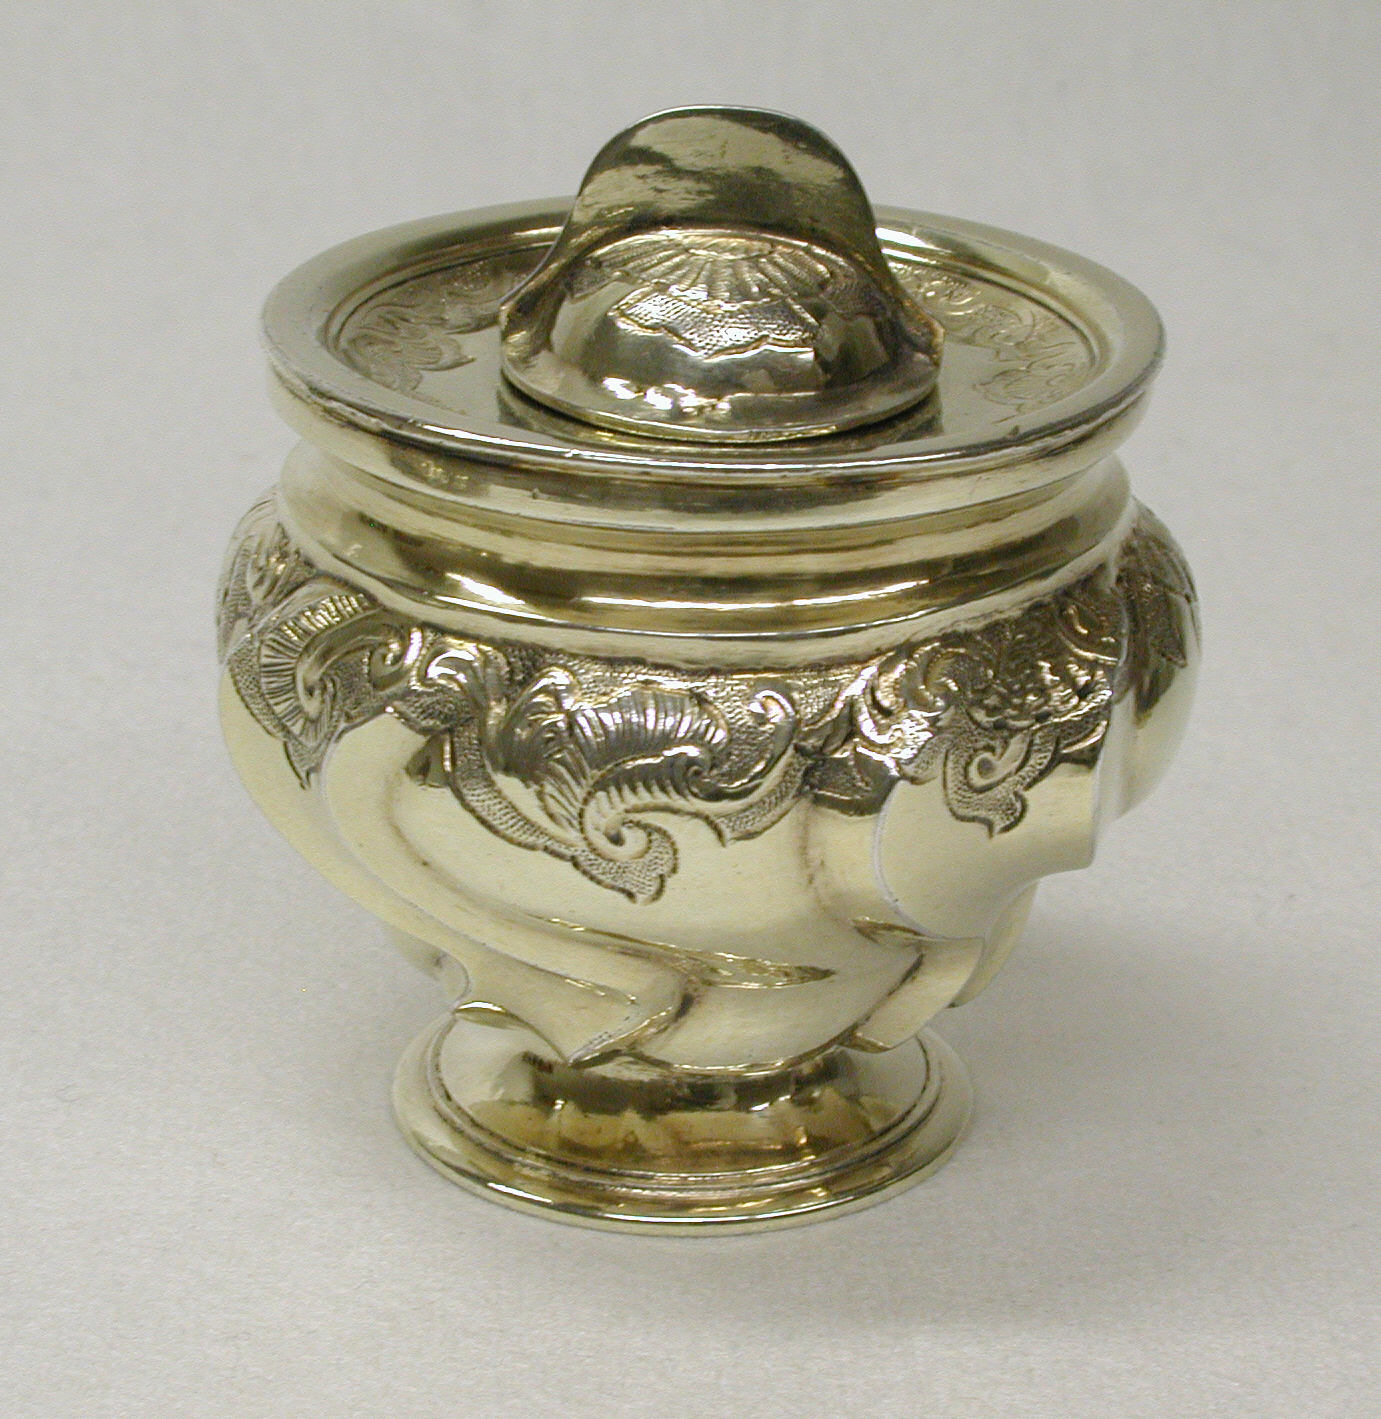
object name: inkwell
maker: abraham drentwett iv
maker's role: maker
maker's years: 1711-1785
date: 1743-1745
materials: silver gilt